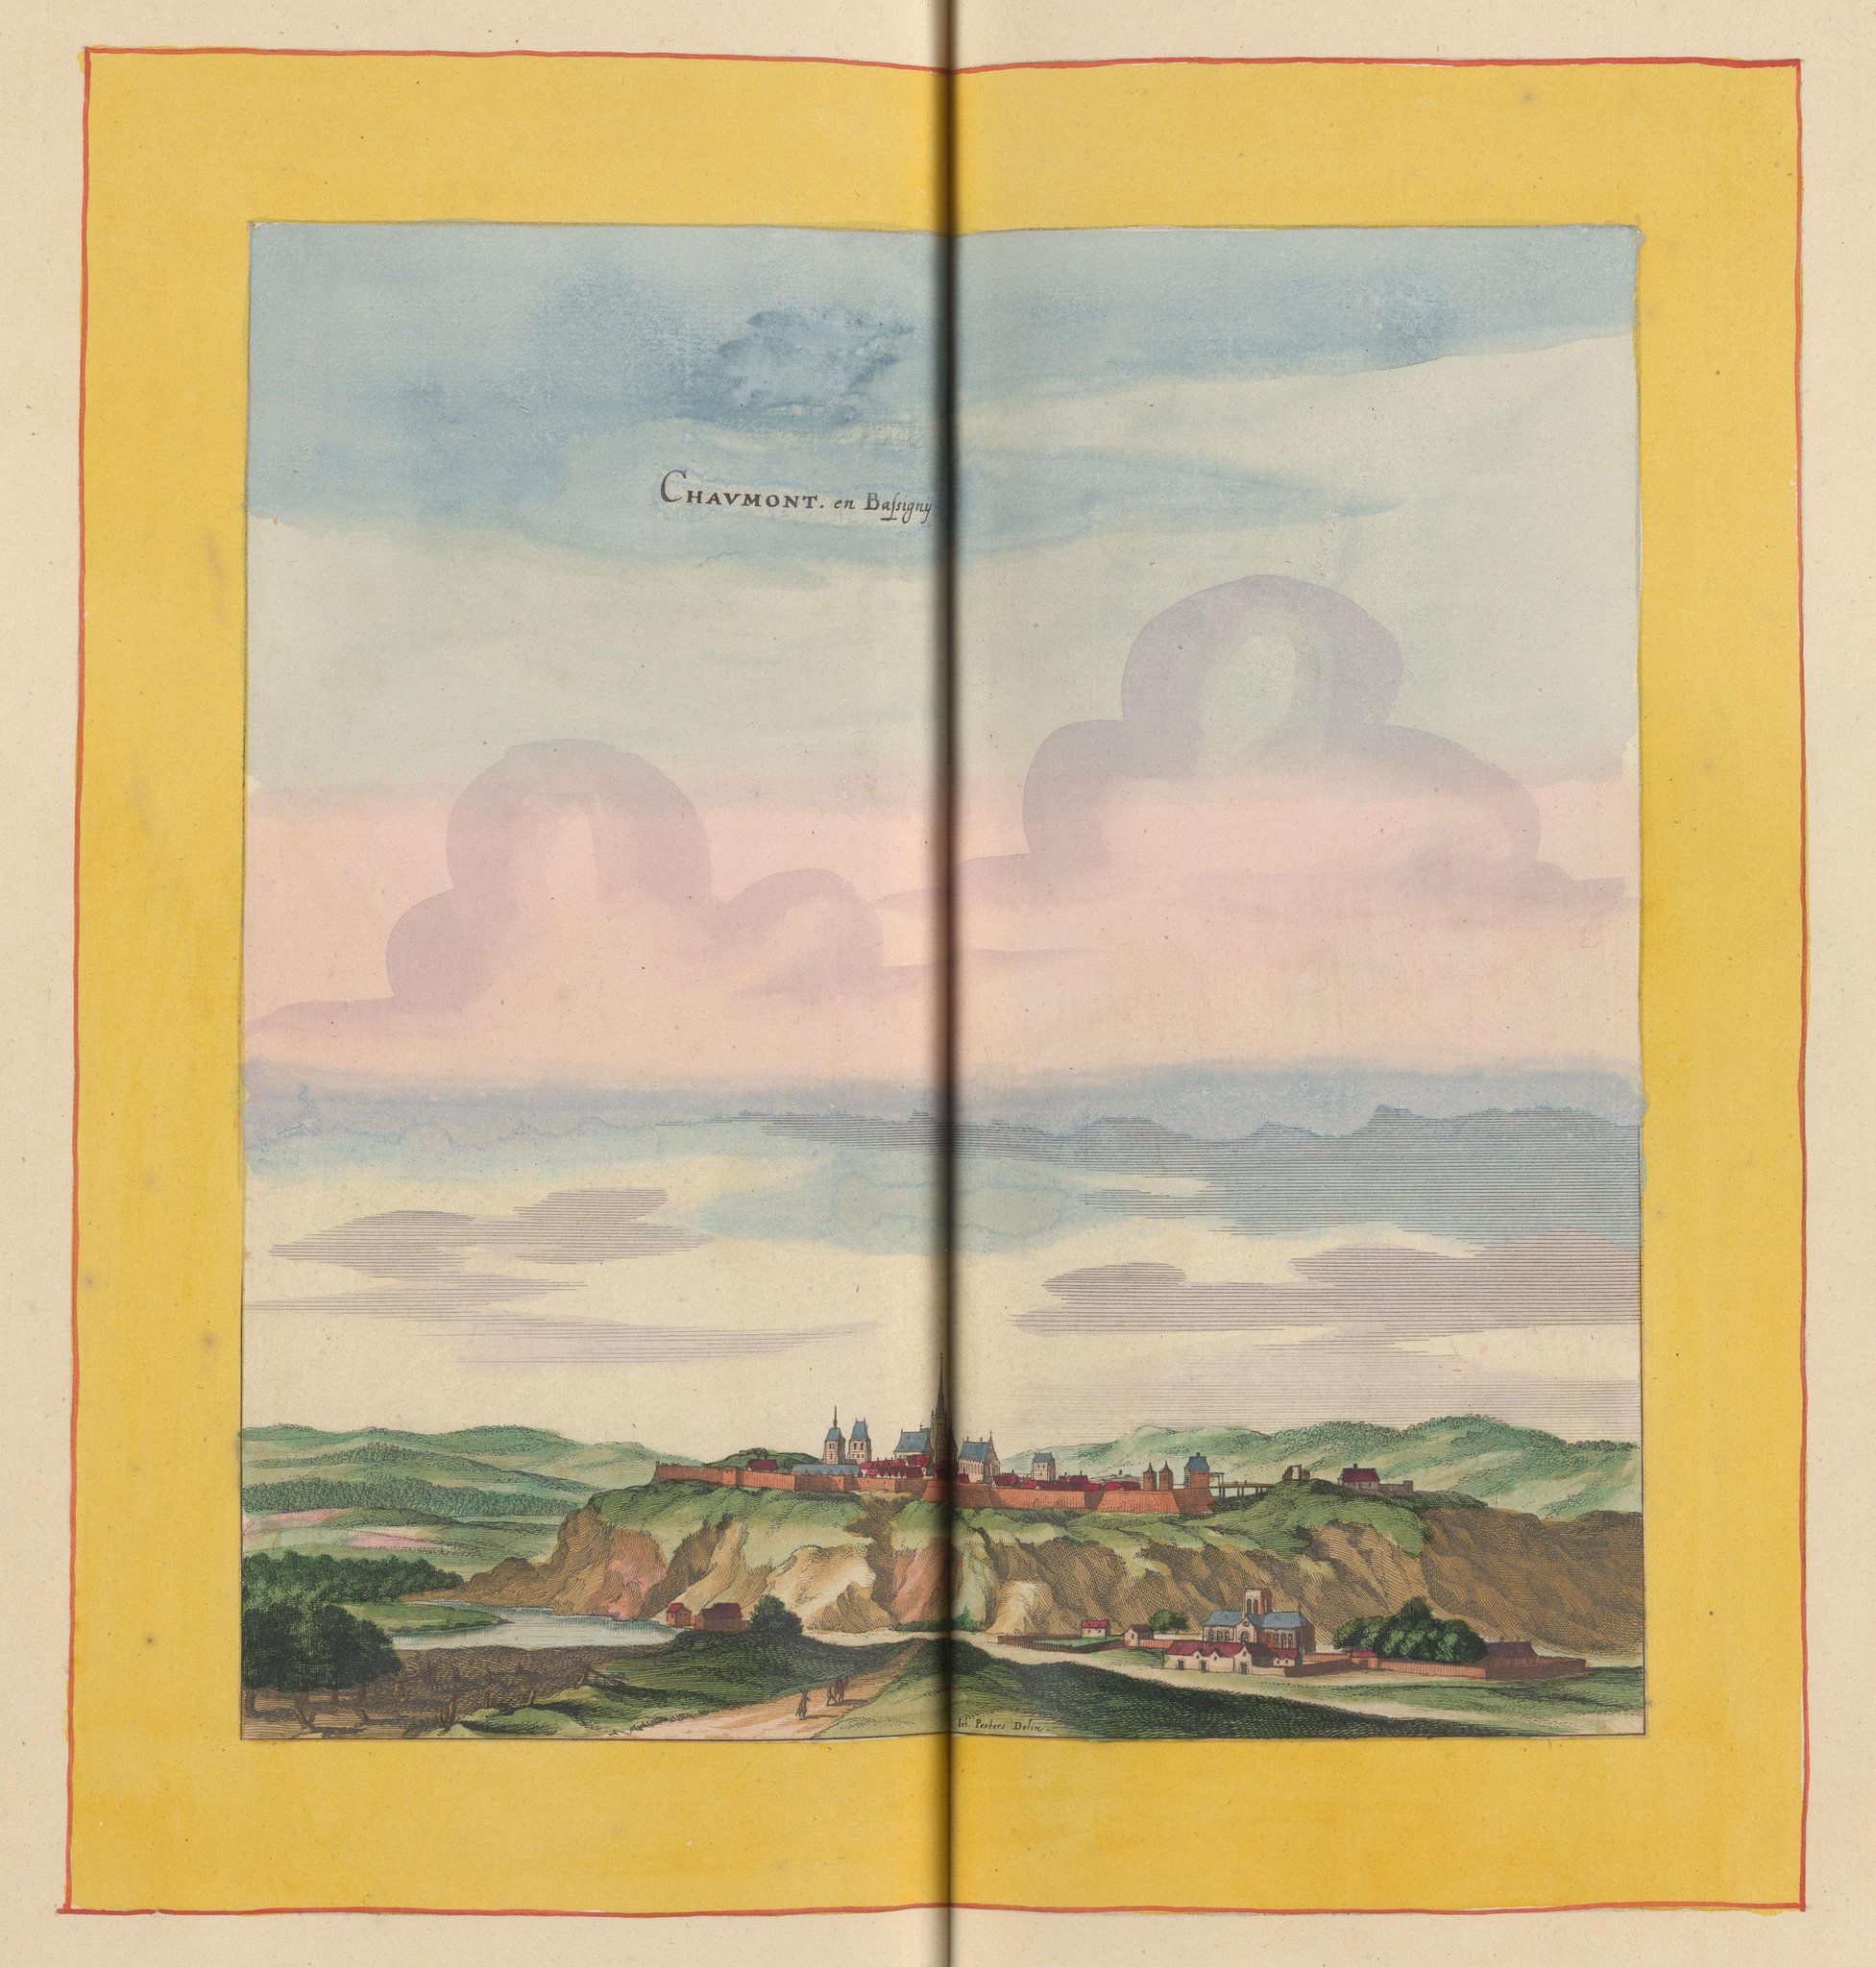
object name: album leaf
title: Chaumont, en Bassigny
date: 1656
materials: paper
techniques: engraving, hand coloring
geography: frankfurt am main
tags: city-view in general; 'veduta'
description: Prent uit: Zeiller, Martin. Topographia Galliae. 13 dln. Frankfurt: Caspar Merian, 1656, dl. 3, na p. 8. Origineel op één blad gedrukt met een gezicht op Charleville-Mézières (RP-P-1957-607-96-1(R)).